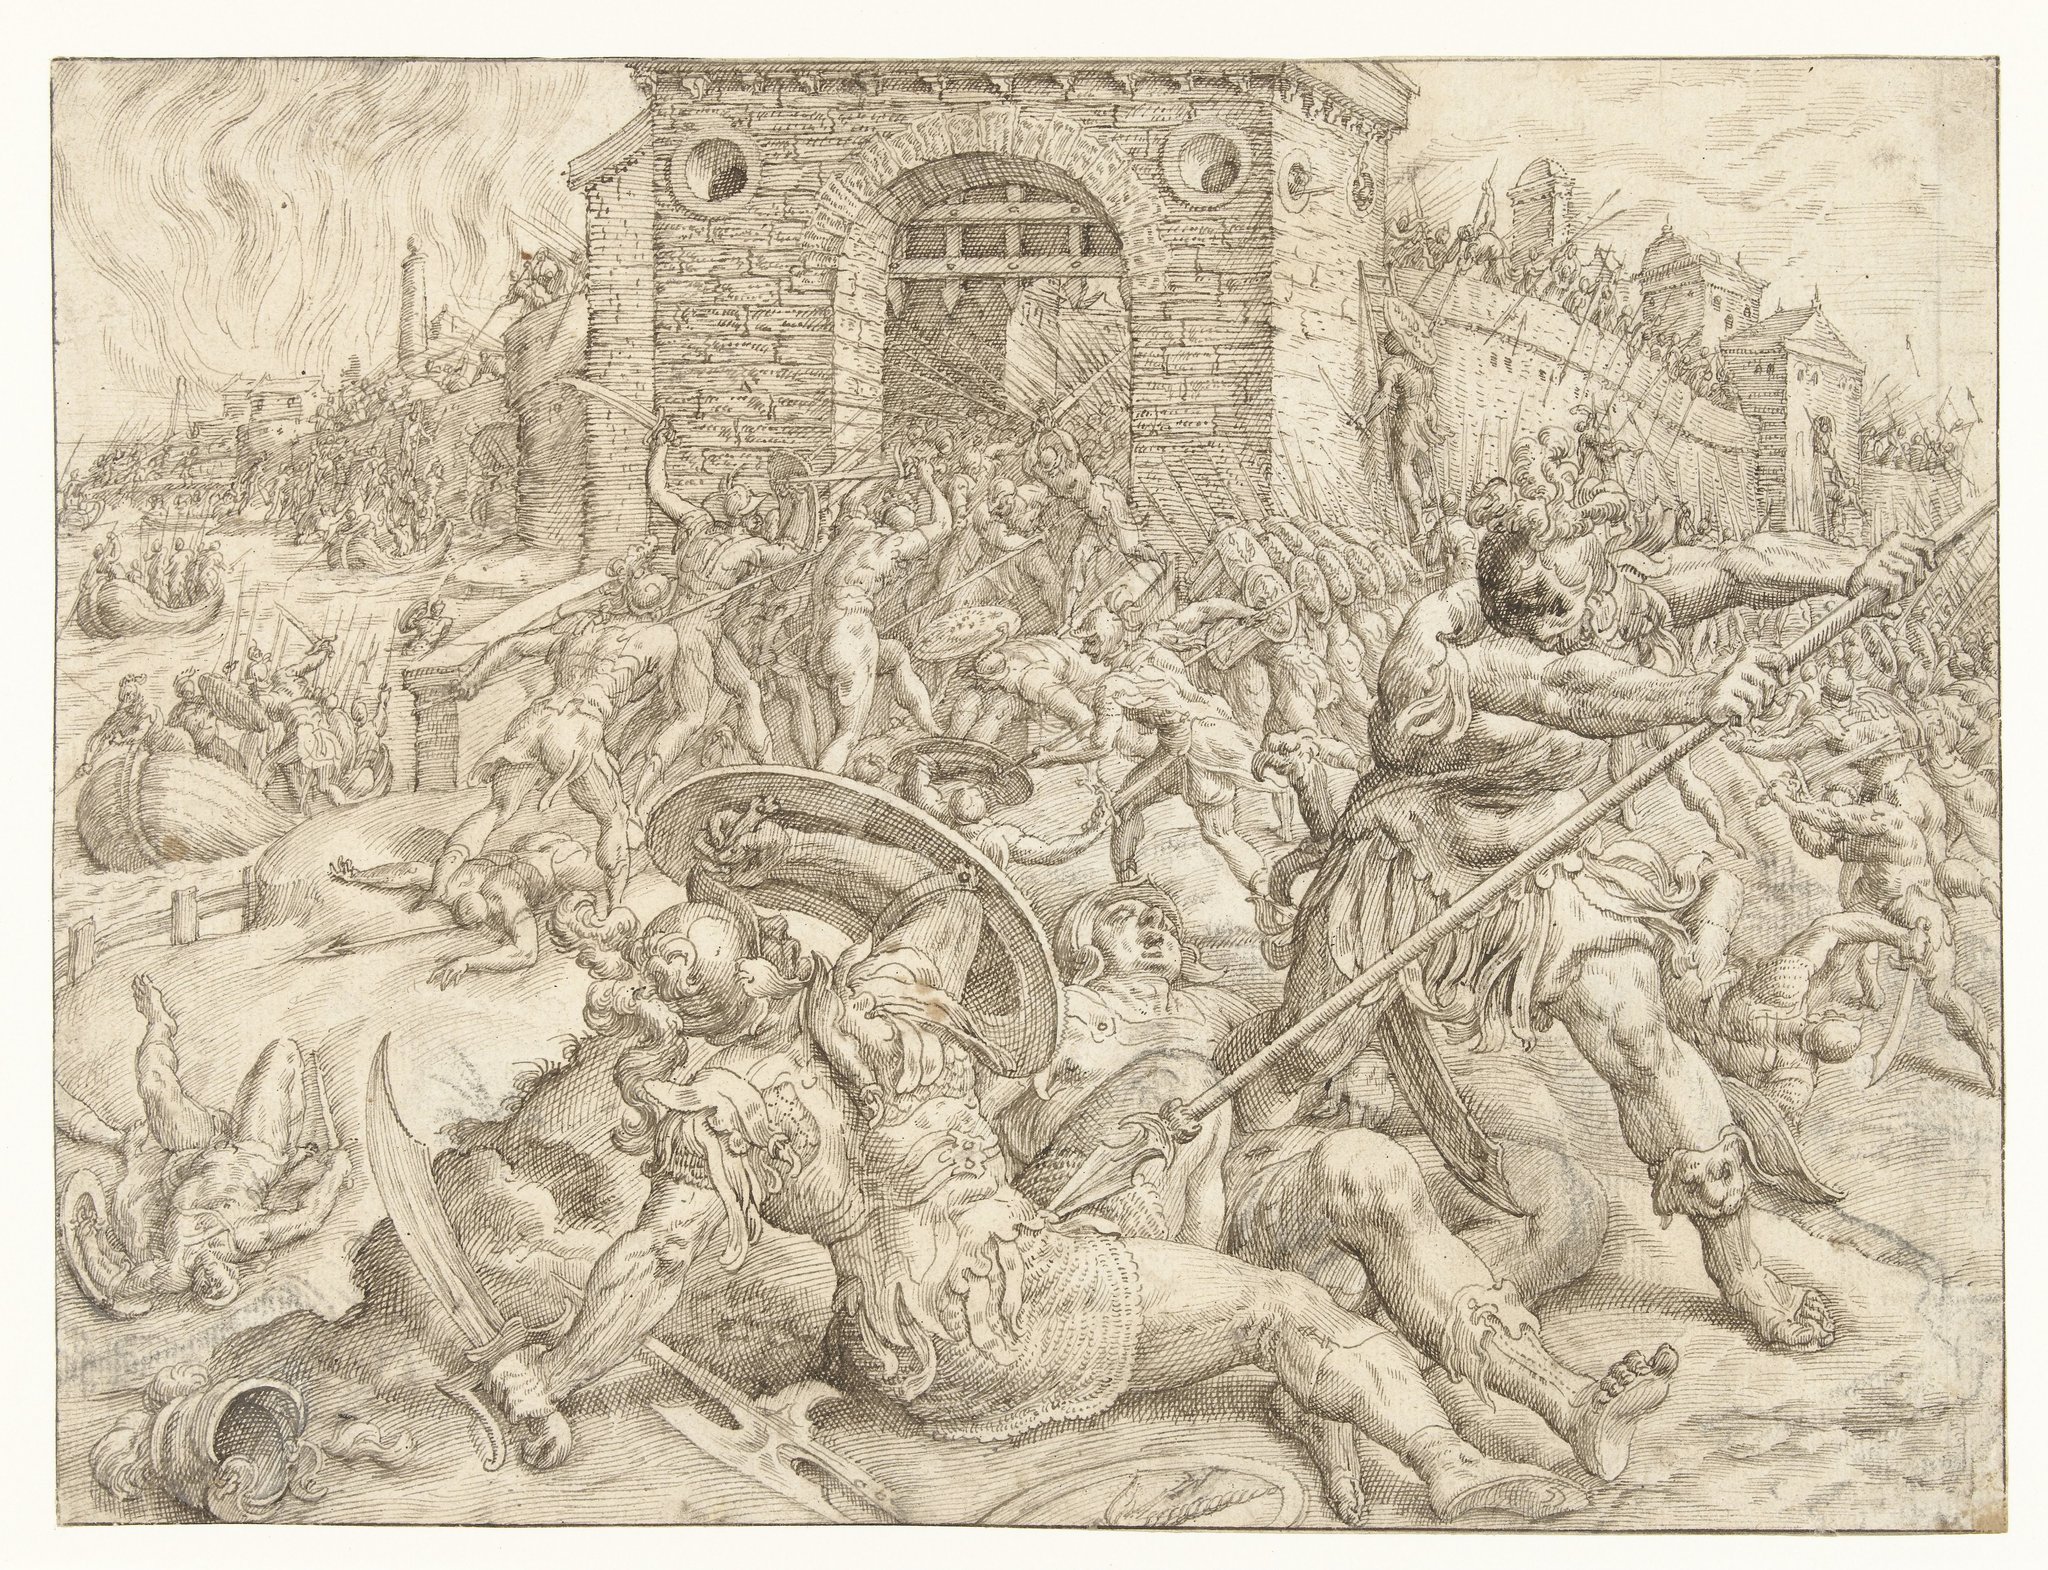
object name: drawing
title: Daden van Scipio Africanus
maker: gerard van groeningen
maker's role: draughtsman, painter, print maker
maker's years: 1515-1599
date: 1560-1580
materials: chalk, ink, paper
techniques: pen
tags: rome, politician, p. cornelius scipio africanus major storming new-carthage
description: Net als het vorige nummer, is deze tekening vroeger geregistreerd onder de naam van Heemskerck. De tekenaar is dezelfde die de studie tekende van Abraham en Melchisedek (cat. nr. 289). In dit geval, echter, is de tekening gegraveerd door Gerad de Jode als nr. 1 in de serie Daden van Scipio Africanus, met de titel 'Strenuitas', maar zonder Groenning als ontwerper te noemen.